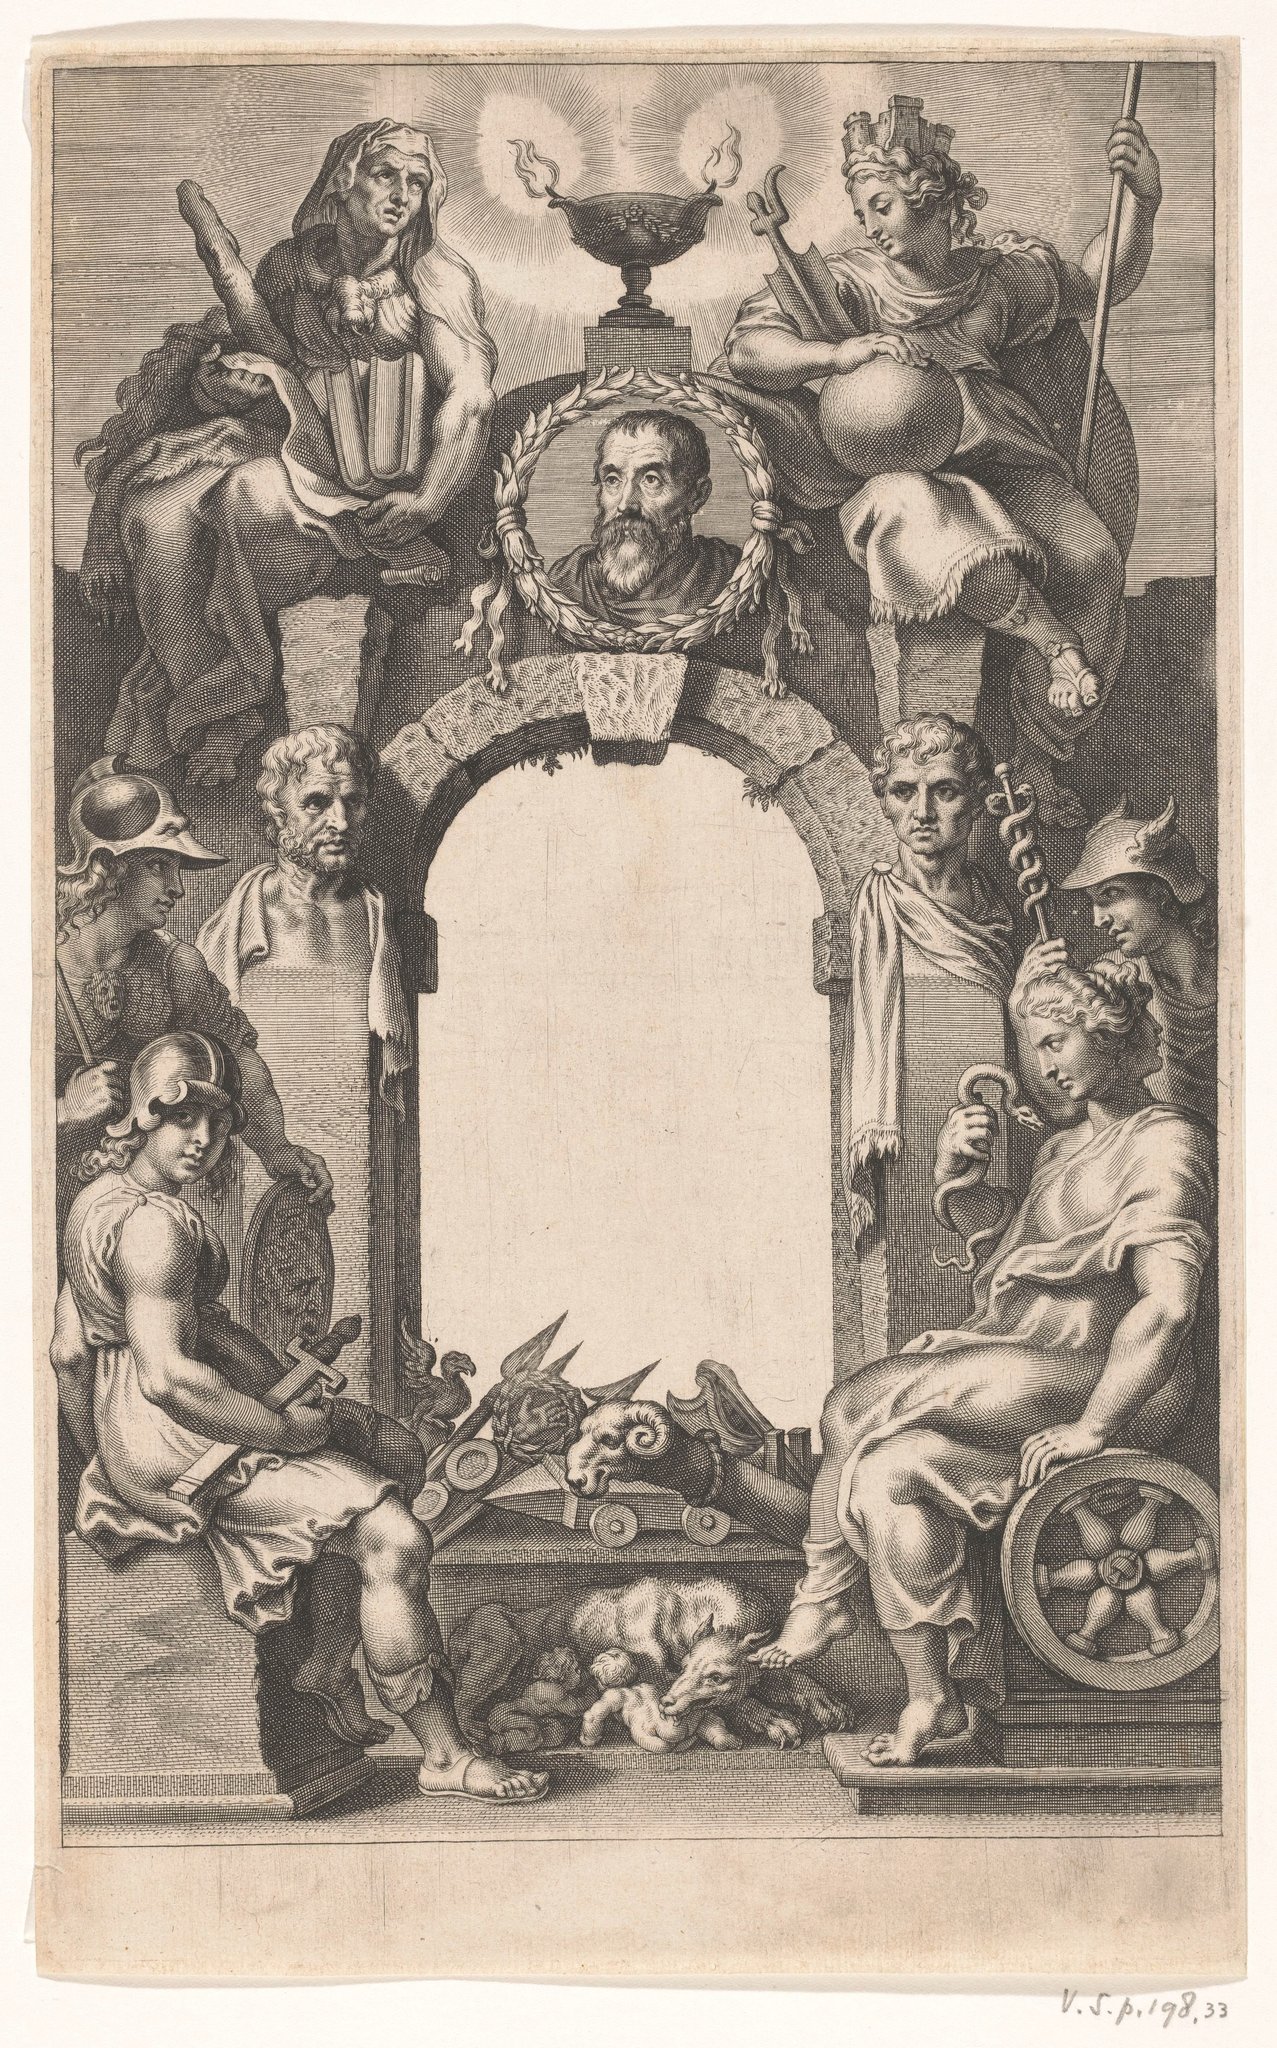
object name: print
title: Allegorische titelpagina met stenen boog met een medaillonportret van Justus Lipsius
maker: cornelis galle (i)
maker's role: print maker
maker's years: 1576-1650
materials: paper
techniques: engraving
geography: southern netherlands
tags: louvain, justus lipsius, romulus and remus are washed ashore and suckled by a she-wolf; 'lupa romana', 'philosophia'; 'filosofia' (ripa), 'politica' (ripa)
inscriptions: collector's mark: Lugt 240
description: Op een stenen boog is een medaillonportret van de schrijver Justus Lipsius geplaatst. Aan weerszijden verbeelden de personificaties van de Filosofie en de Politiek de hoofdonderwerpen binnen zijn oeuvre. Naast de boog twee portretbustes van antieke auteurs die Lipsius heeft geëditeerd: Seneca en Tacitus. Ernaast Minerva en Mercurius en de zittende personificaties van Deugd (links) en Voorzichtigheid (rechts). Proefdruk van een titelpagina voor Lipsius' verzamelde werken.